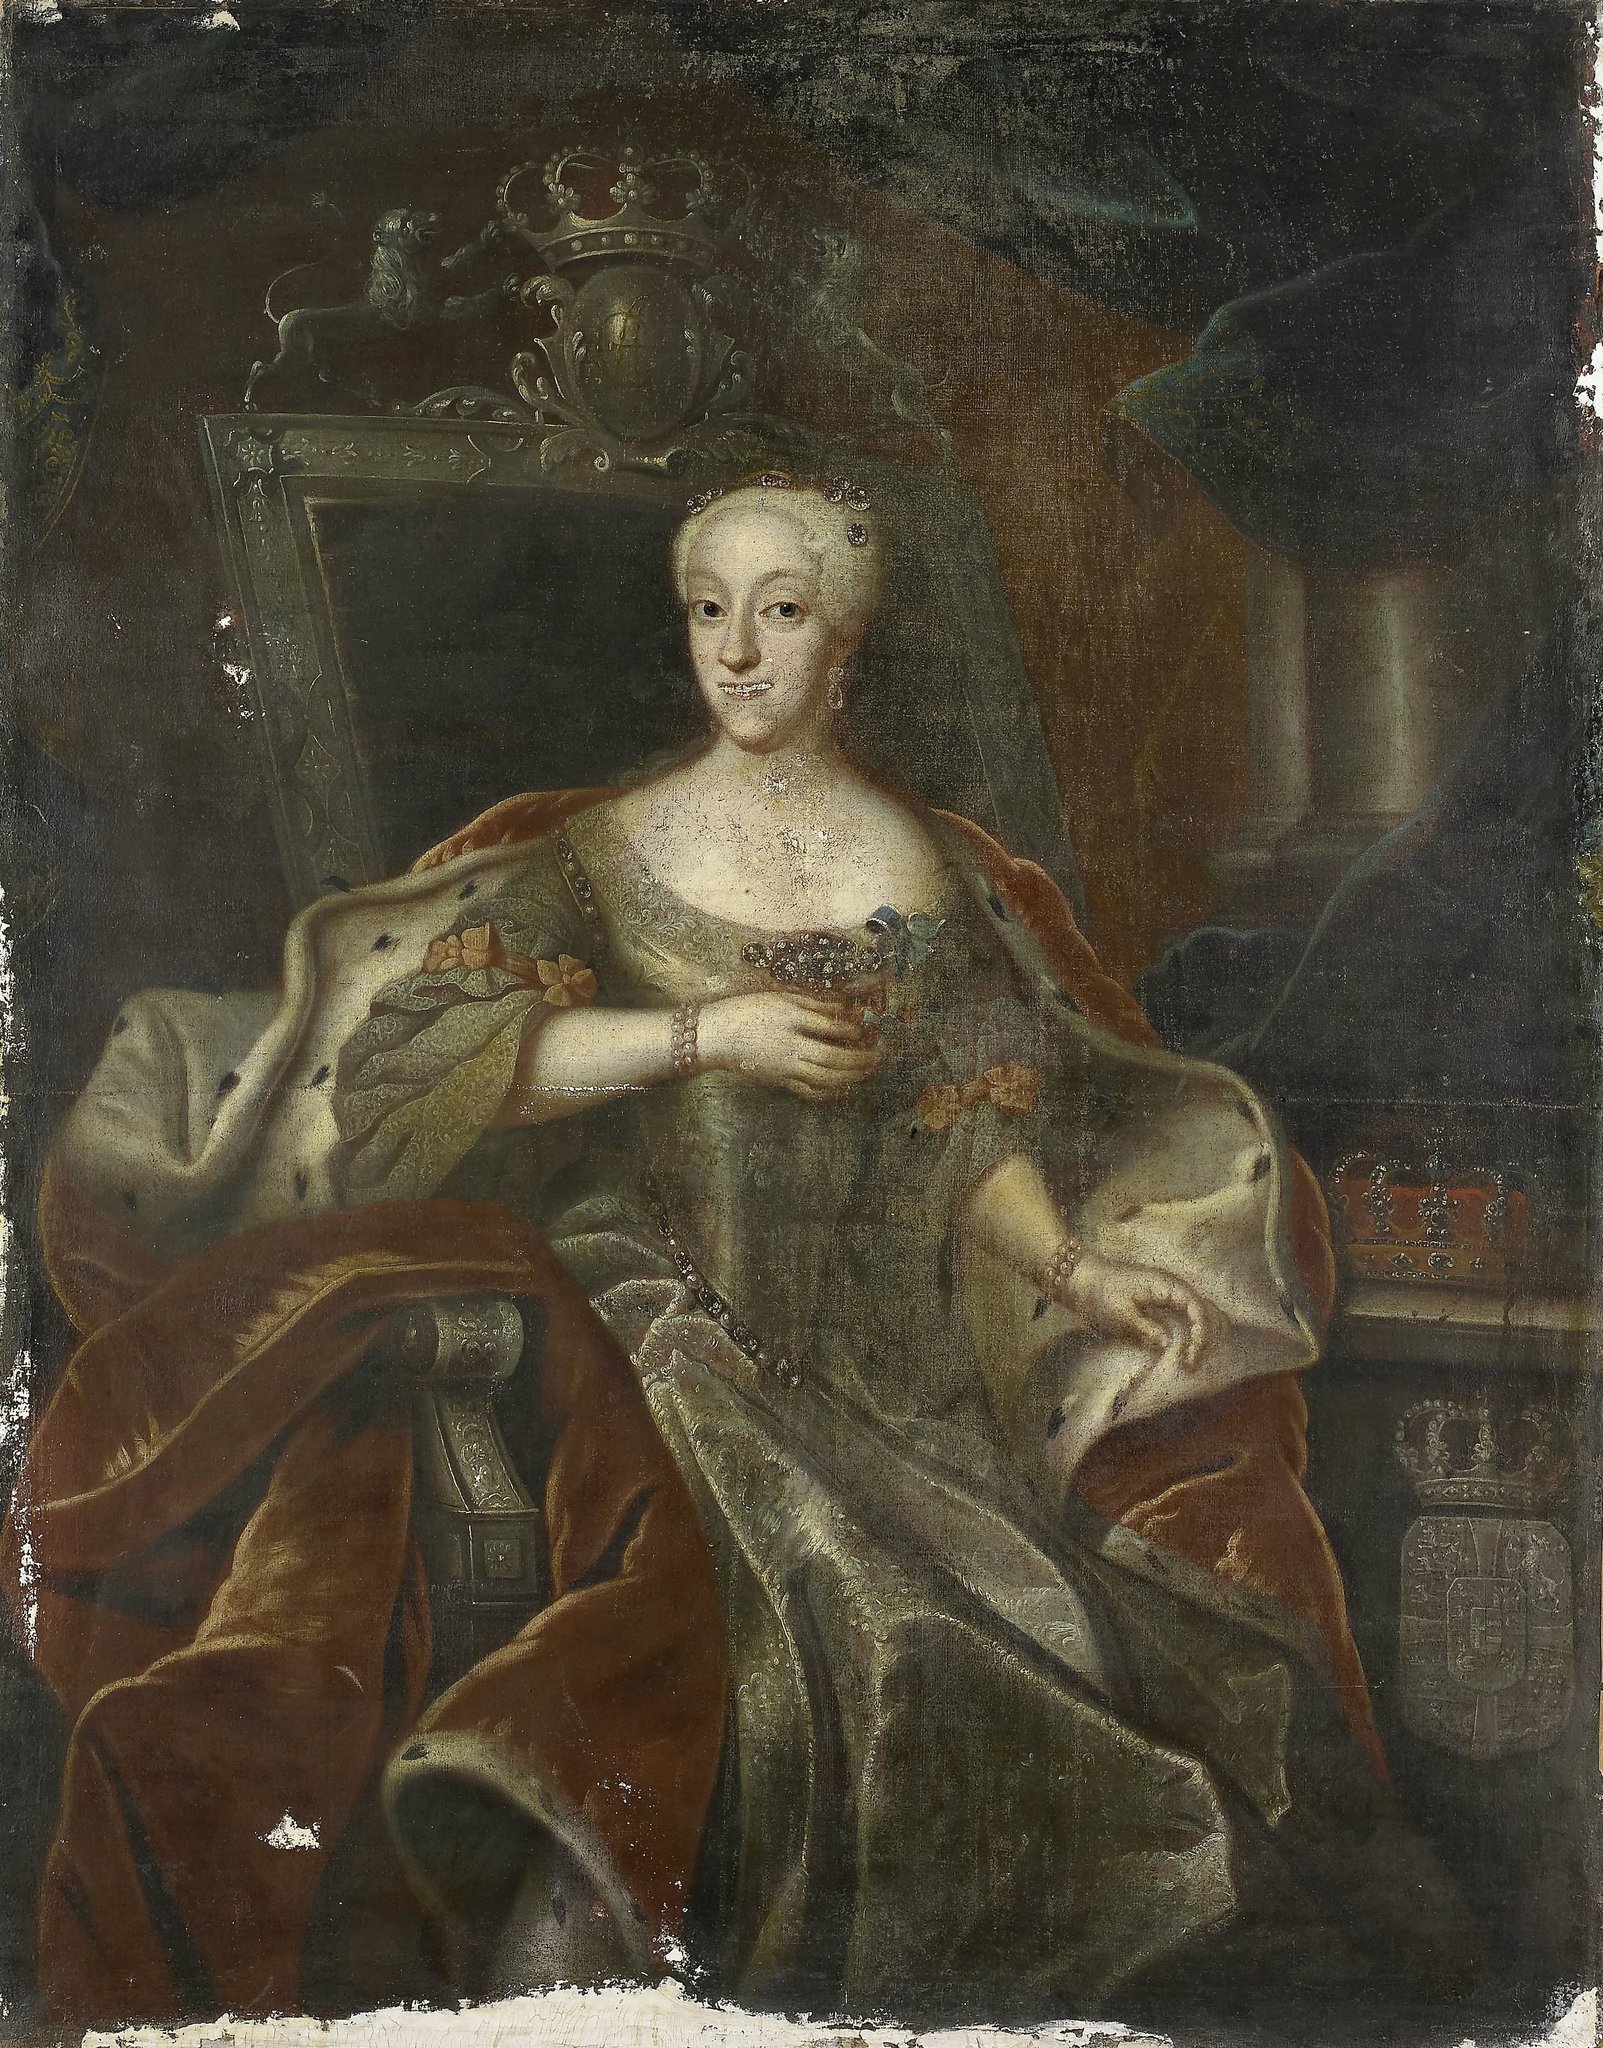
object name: painting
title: Portrait of Princess Charlotte Amalie, Daughter of Frederick IV, King of Denmark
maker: Anonymous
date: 1755-1765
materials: canvas, oil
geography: denmark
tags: historical persons - bb - woman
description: Portret van Charlotte Amalie (1706-82), dochter van Frederik IV, koning van Denemarken. Kniestuk, zittend op een troon, in een hermelijnen mantel, met de rechterhand voor de borst.